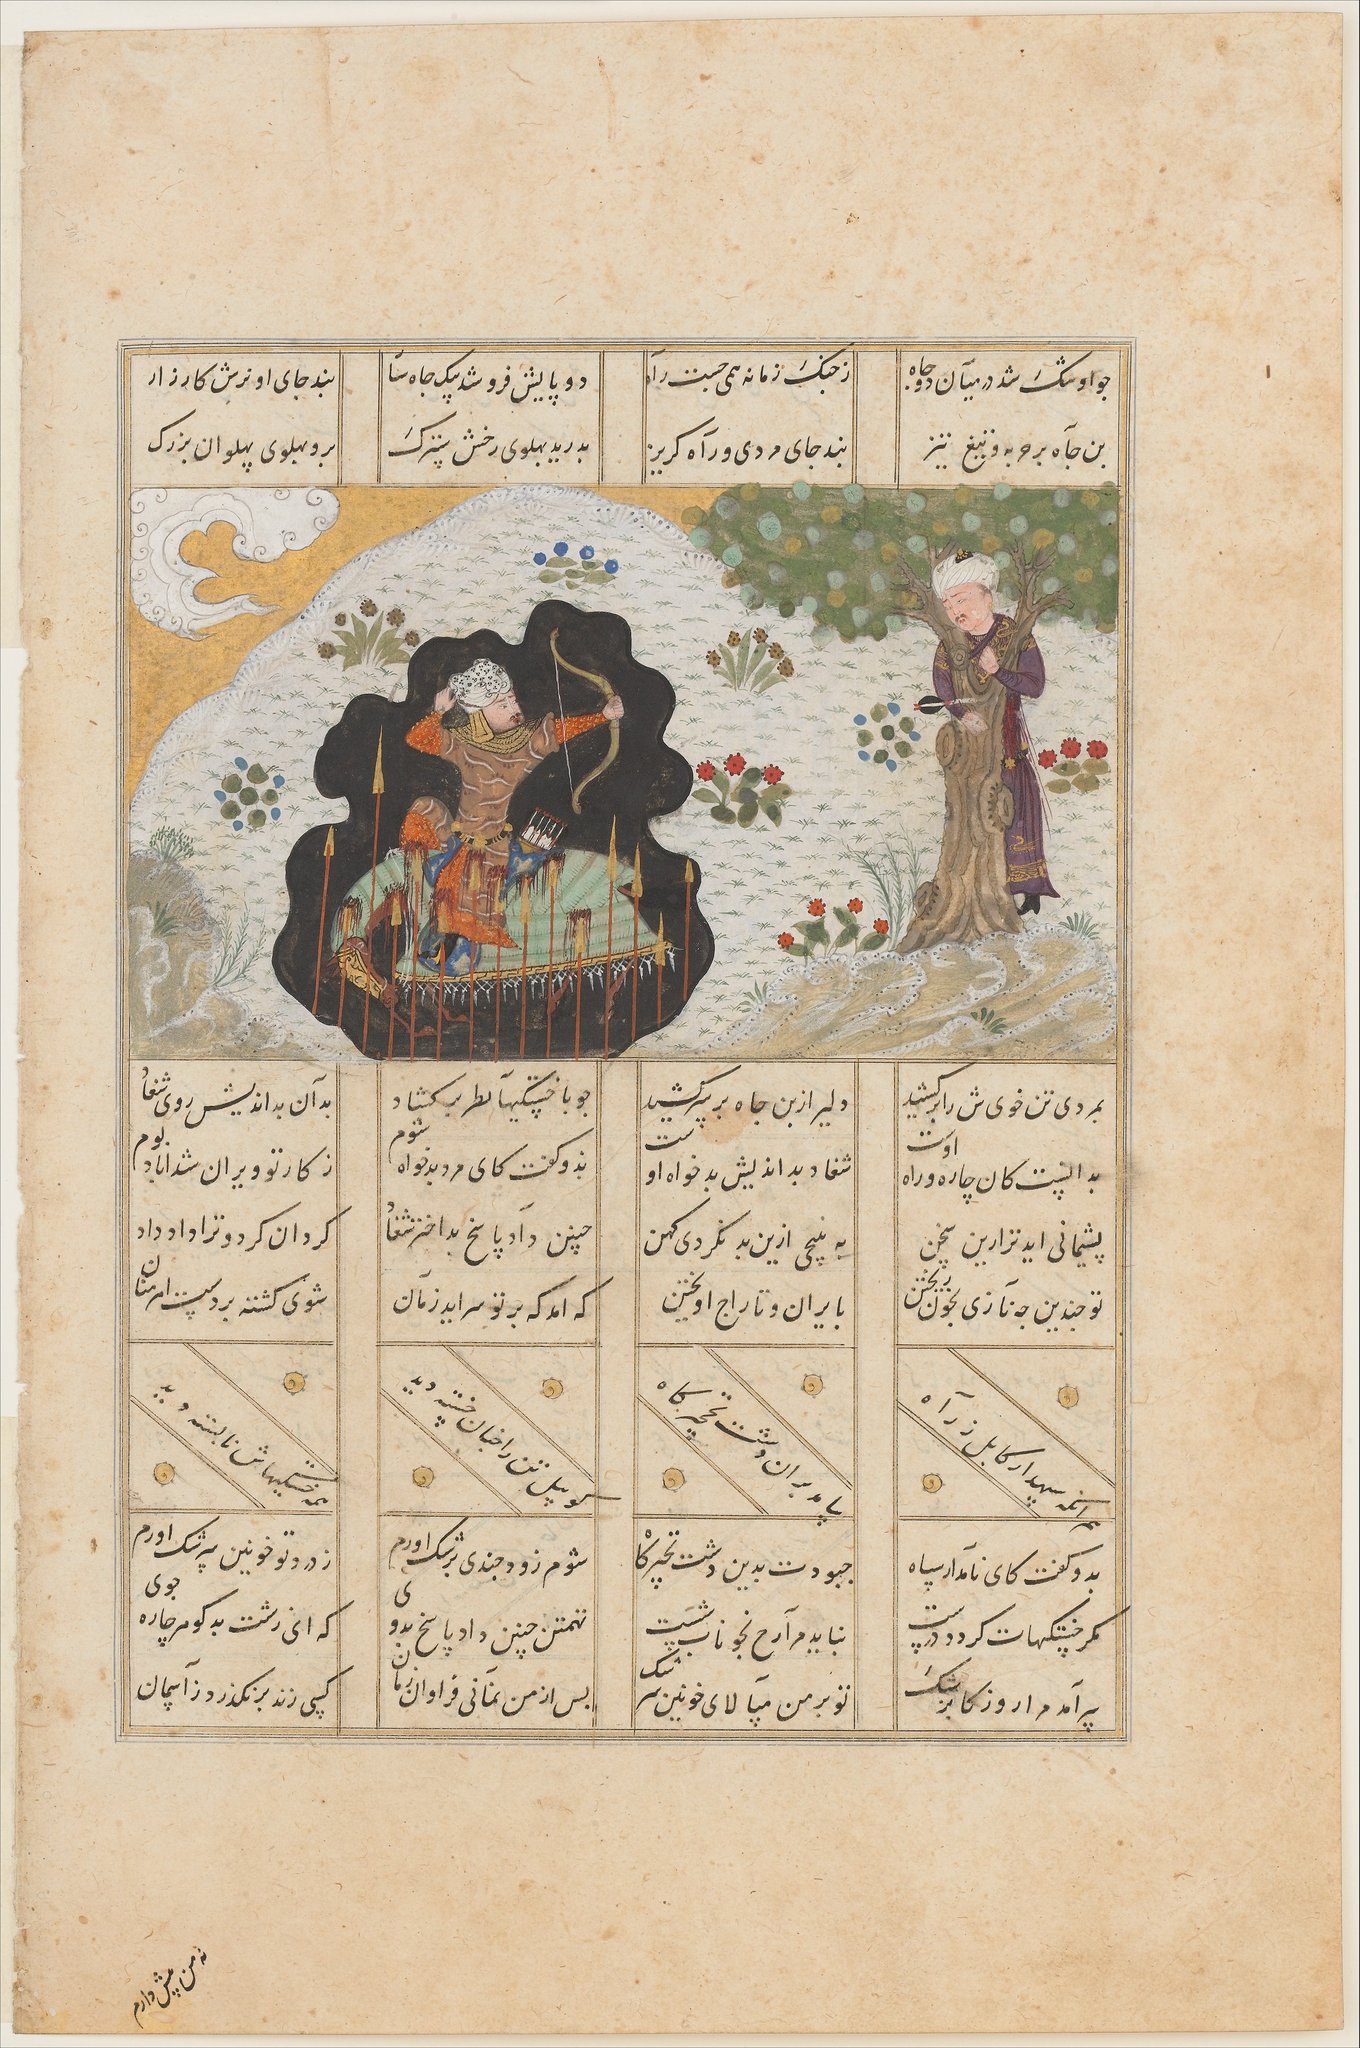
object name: folio from an illustrated manuscript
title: "Rustam Shoots His Half-brother Shaghad through a Plane Tree", Folio from a Shahnama (Book of Kings) of Firdausi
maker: abu'l qasim firdausi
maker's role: author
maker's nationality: iranian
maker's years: 935-1020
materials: gold, ink, paper, watercolor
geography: iran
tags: bow and arrow,men,trees